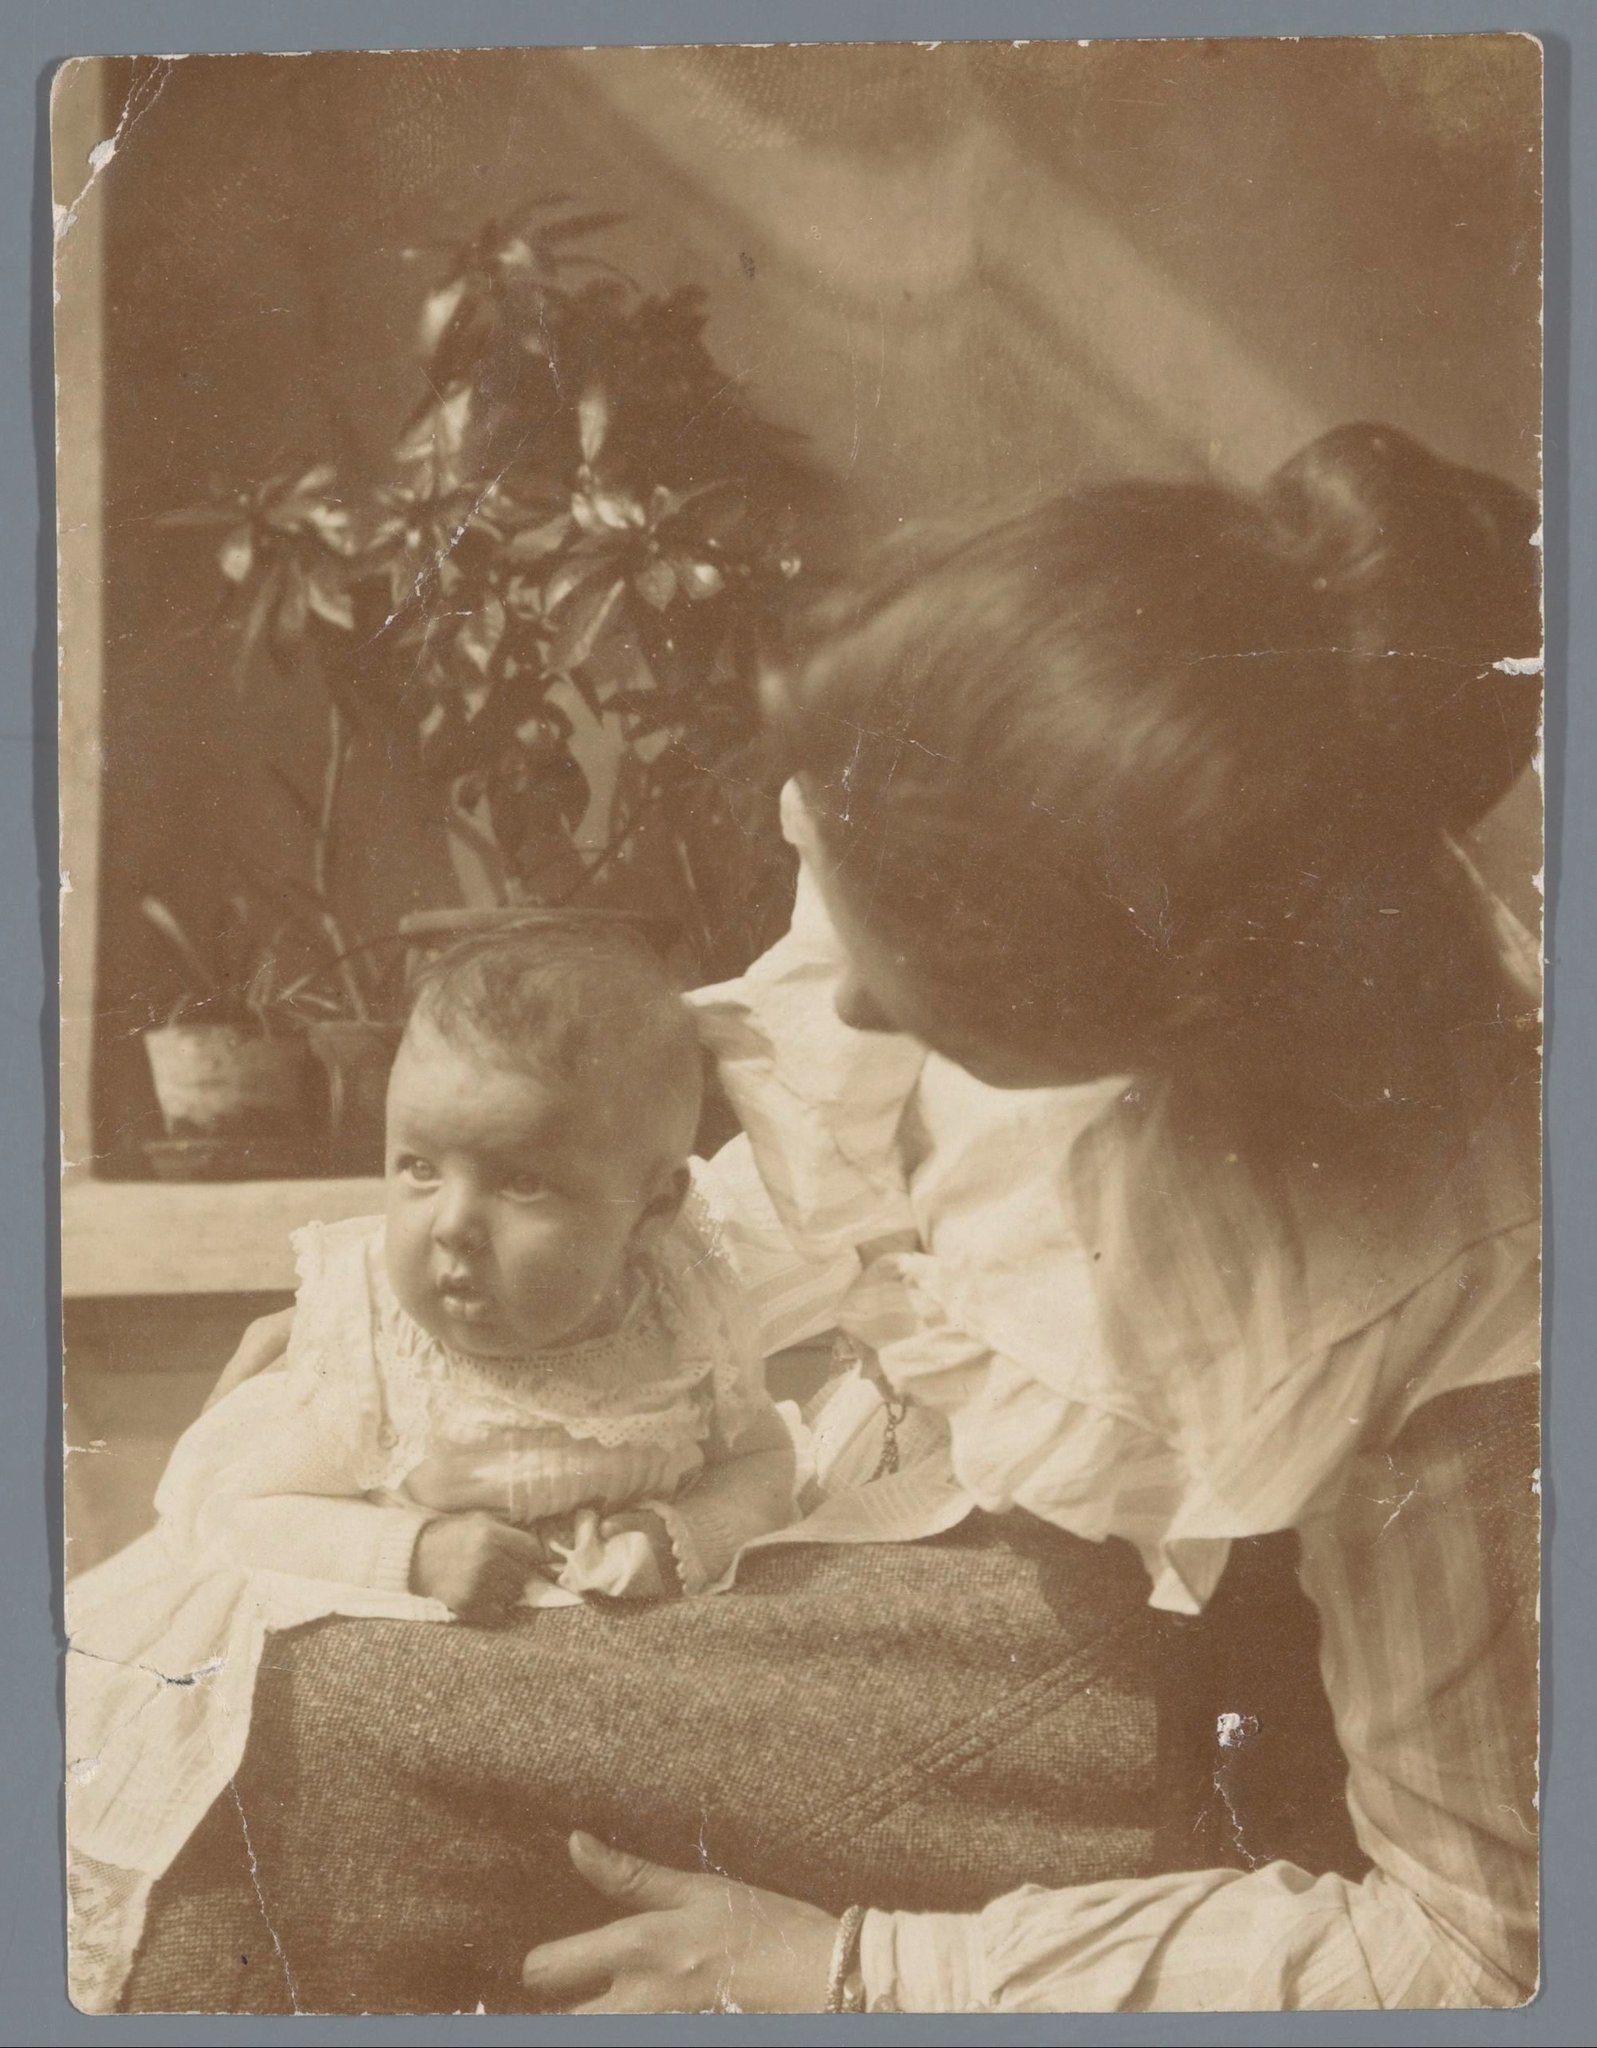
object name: photograph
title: Portret van een vrouw met baby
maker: Anonymous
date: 1903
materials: photographic support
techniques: gelatin silver print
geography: germany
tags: mother and baby or young child